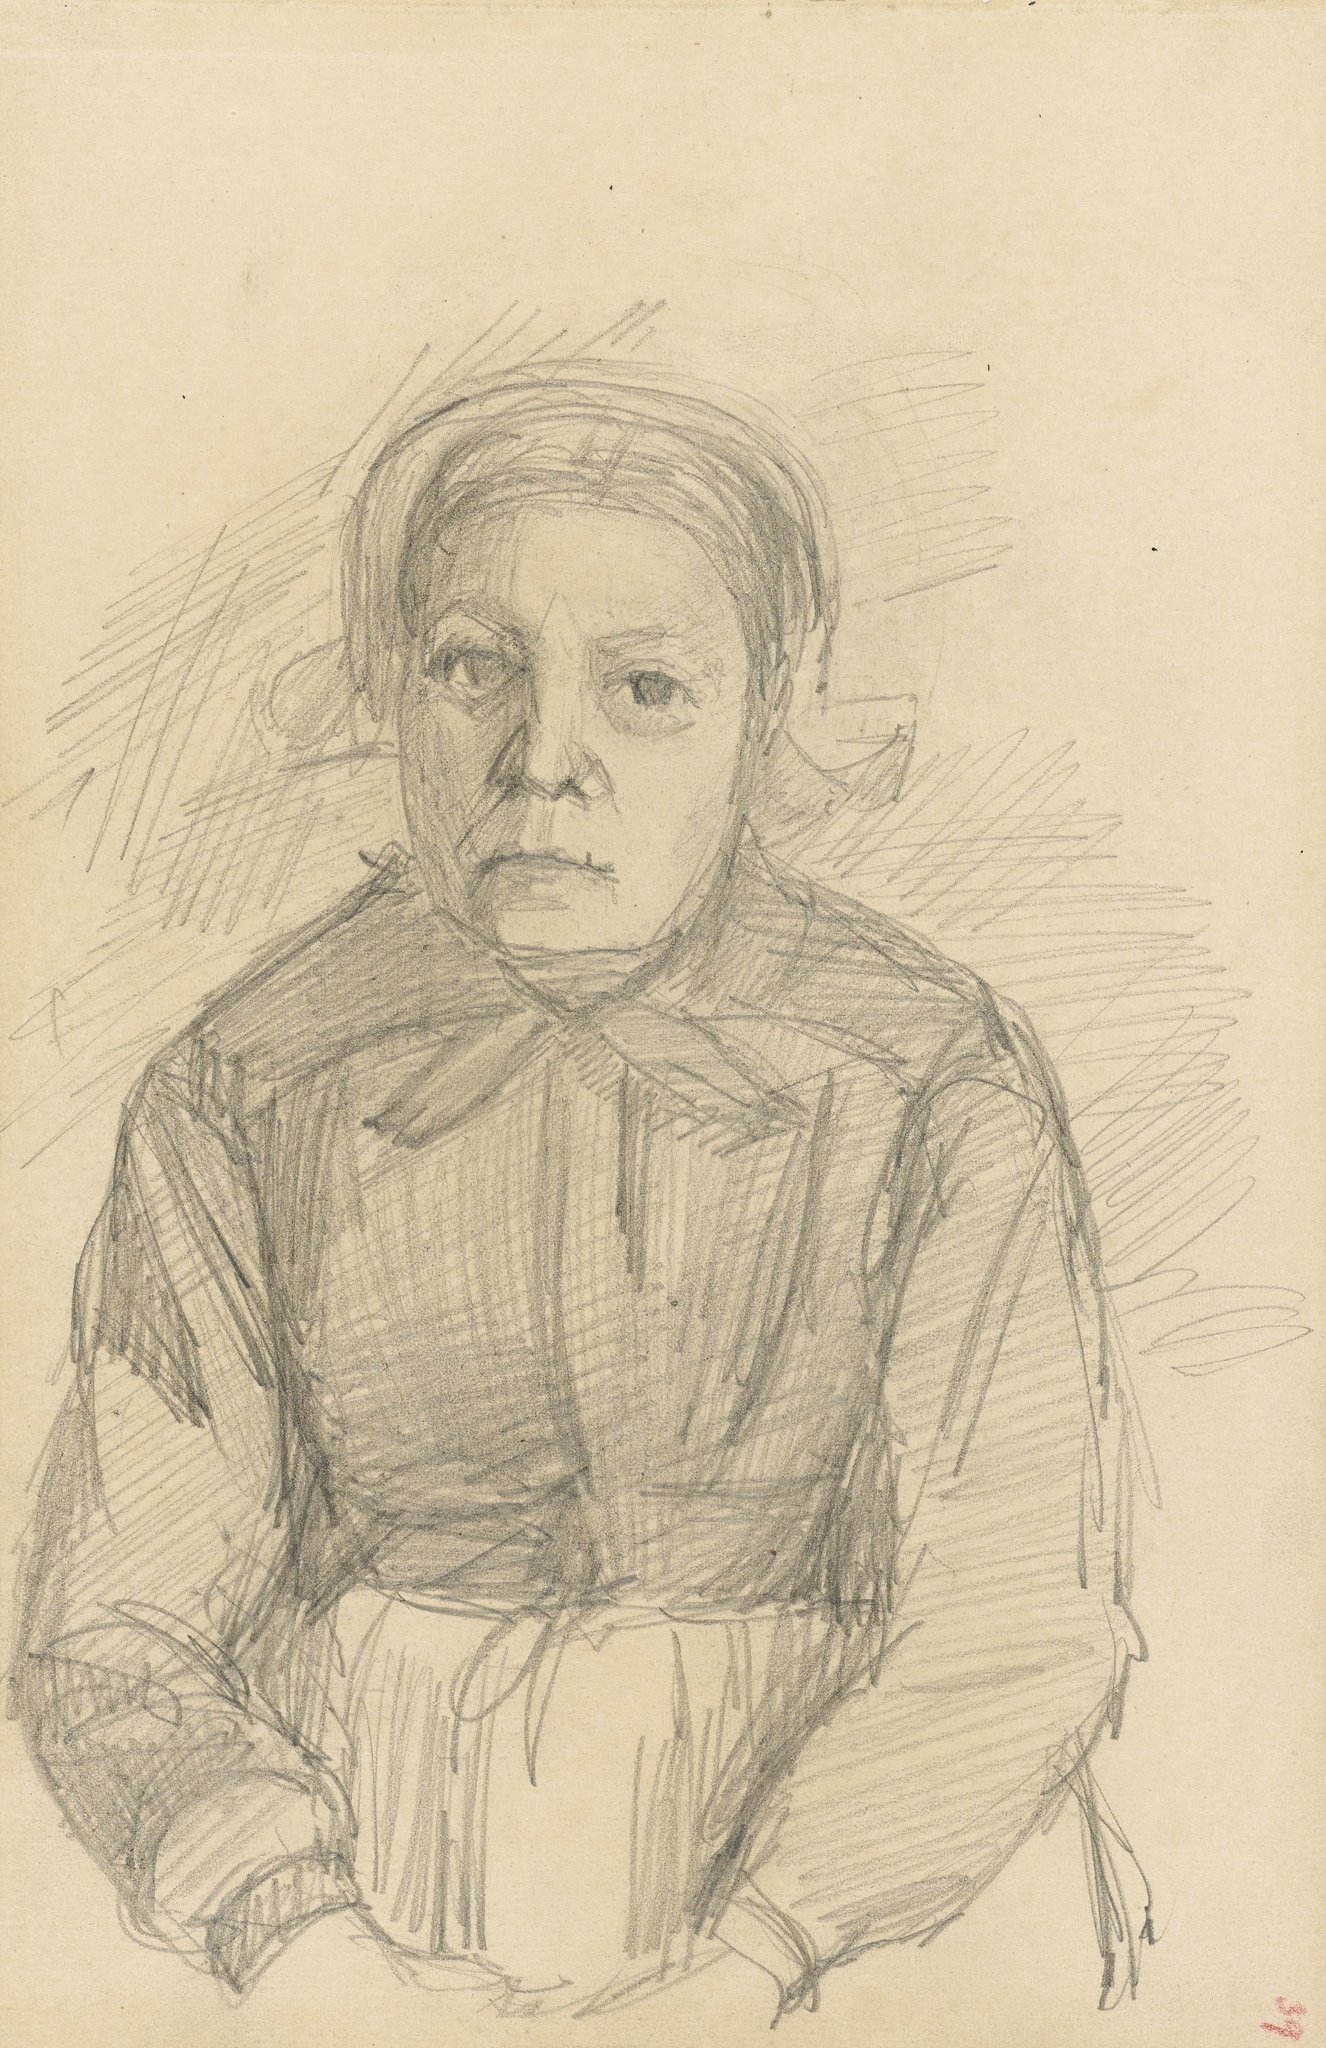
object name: drawing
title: Vrouw met kapje, van voren, ten halven lijve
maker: jozef israëls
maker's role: draughtsman, painter, print maker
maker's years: 1824-1911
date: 1834-1911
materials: paper, pencil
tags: anonymous historical person portrayed alone